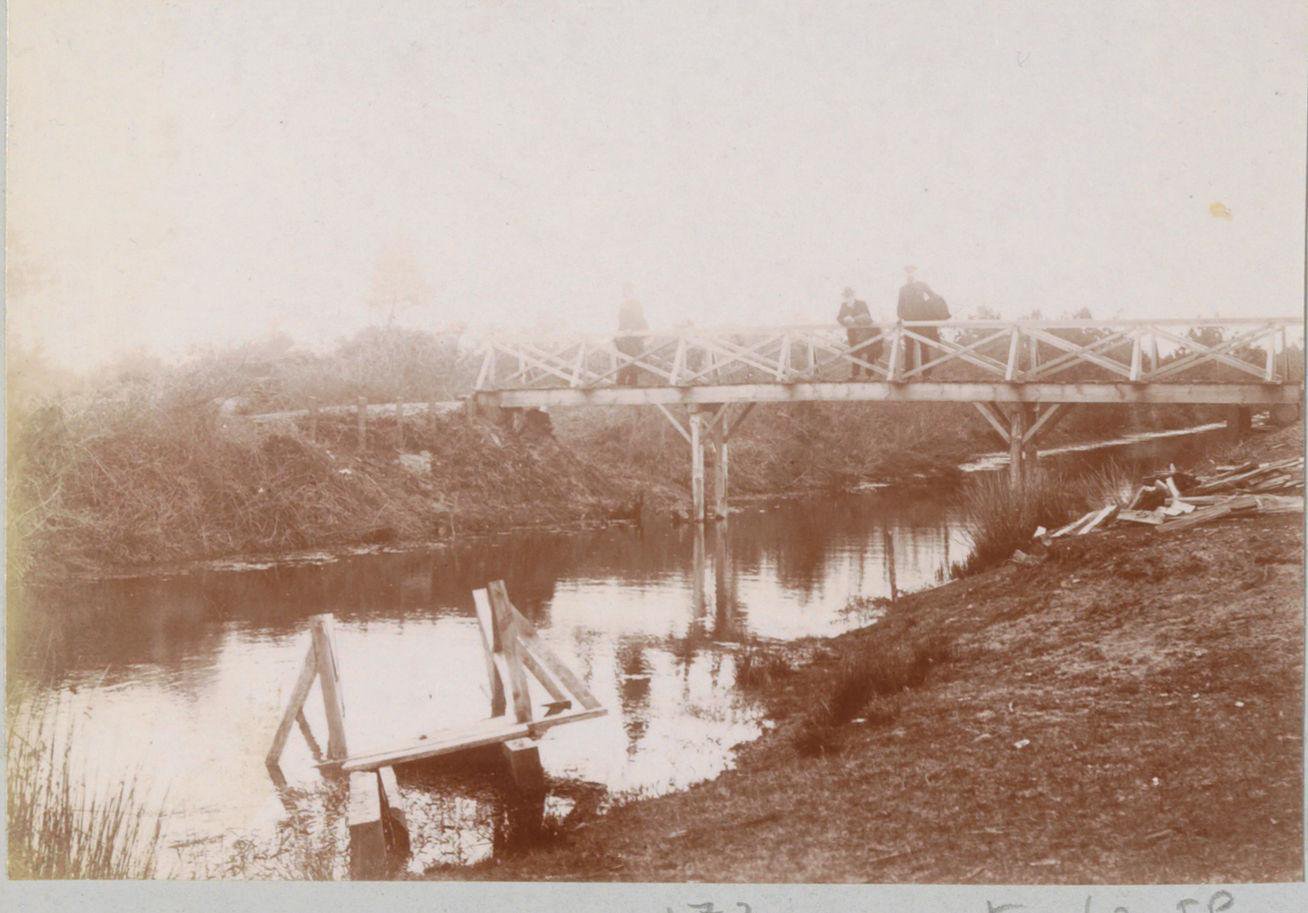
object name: photograph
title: Drie personen op een brug over een sloot in Frankrijk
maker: delizy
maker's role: manufacturer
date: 1898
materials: paper, photographic support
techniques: gelatin silver print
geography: france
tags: landscape with bridge, viaduct or aqueduct, small canal, ditch, france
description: Onderdeel van Fotoalbum van een Franse amateurfotograaf met opnames van uitstapjes in Frankrijk, Spanje, België, Luxemburg en Nederland, de eerste automobielen en autoraces.